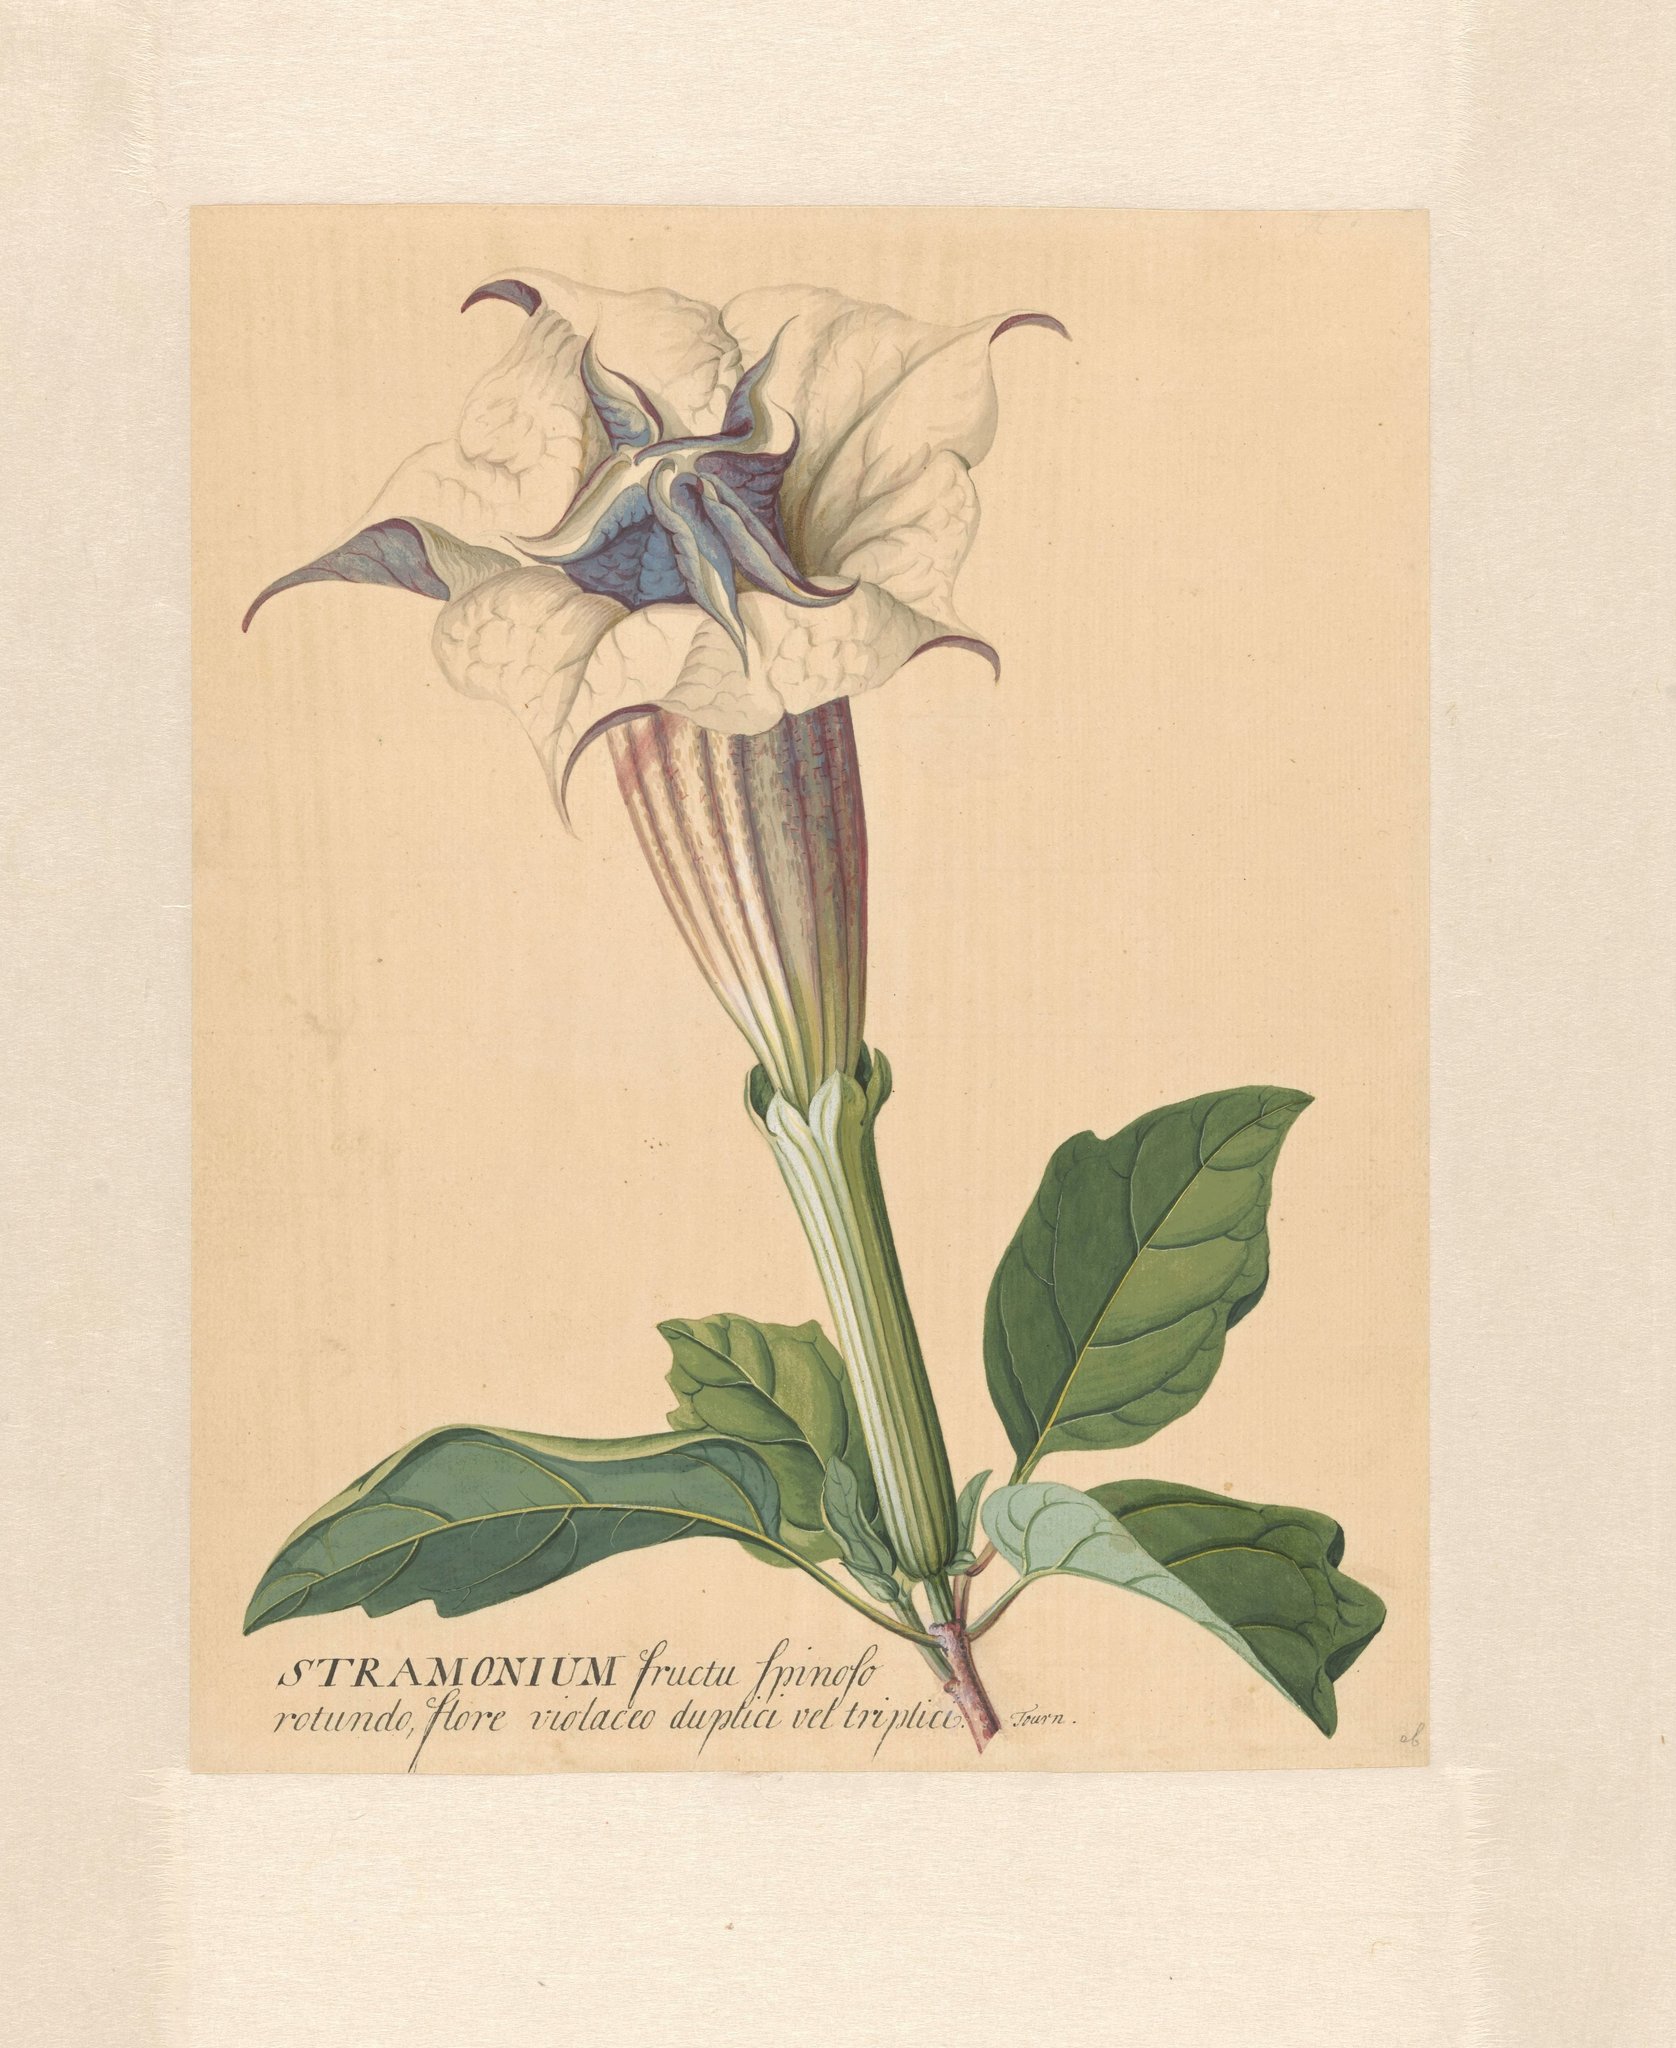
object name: drawing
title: Stramonium furtu spinoso rond (...)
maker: hendrik schwegman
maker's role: draughtsman, print maker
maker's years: 1761-1816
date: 1771-1816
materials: paper, pencil, watercolor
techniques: brush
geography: netherlands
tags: flowers: datura fastuosa